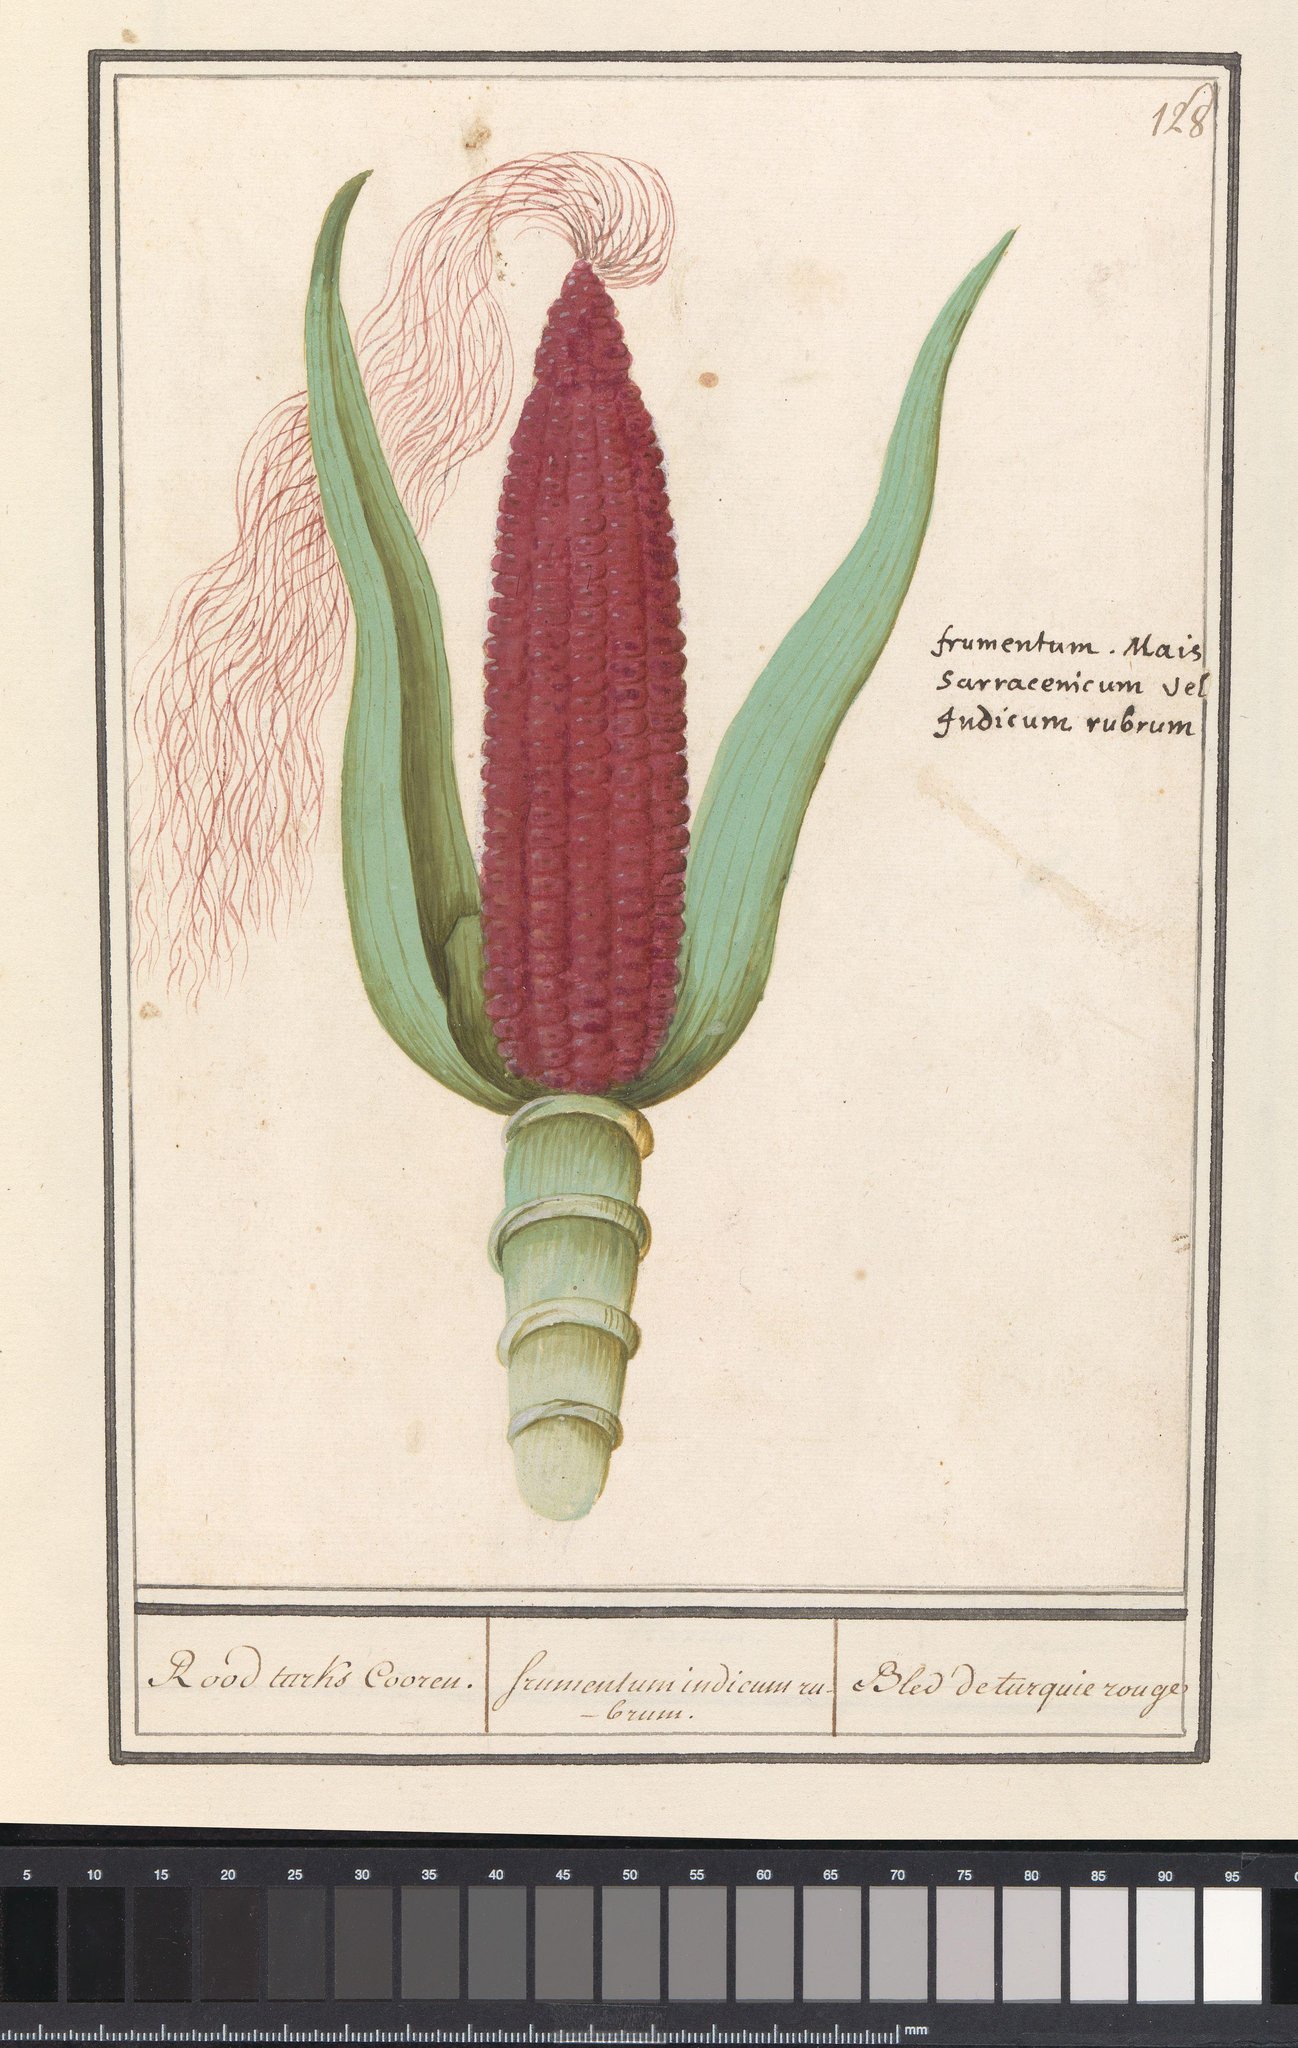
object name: drawing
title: Siermais (Zea mays)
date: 1596-1610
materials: paint, ink, paper, watercolor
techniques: brush, pen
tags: ear of corn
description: Rode siermais. Rechtsboven genummerd: 128. Rechts de Latijnse naam. Onderdeel van het tweede album met tekeningen van bloemen en planten. Negende van twaalf albums met tekeningen van dieren, vogels en planten bekend rond 1600, gemaakt in opdracht van keizer Rudolf II. Met toelichting in Nederlands, Latijn en Frans.